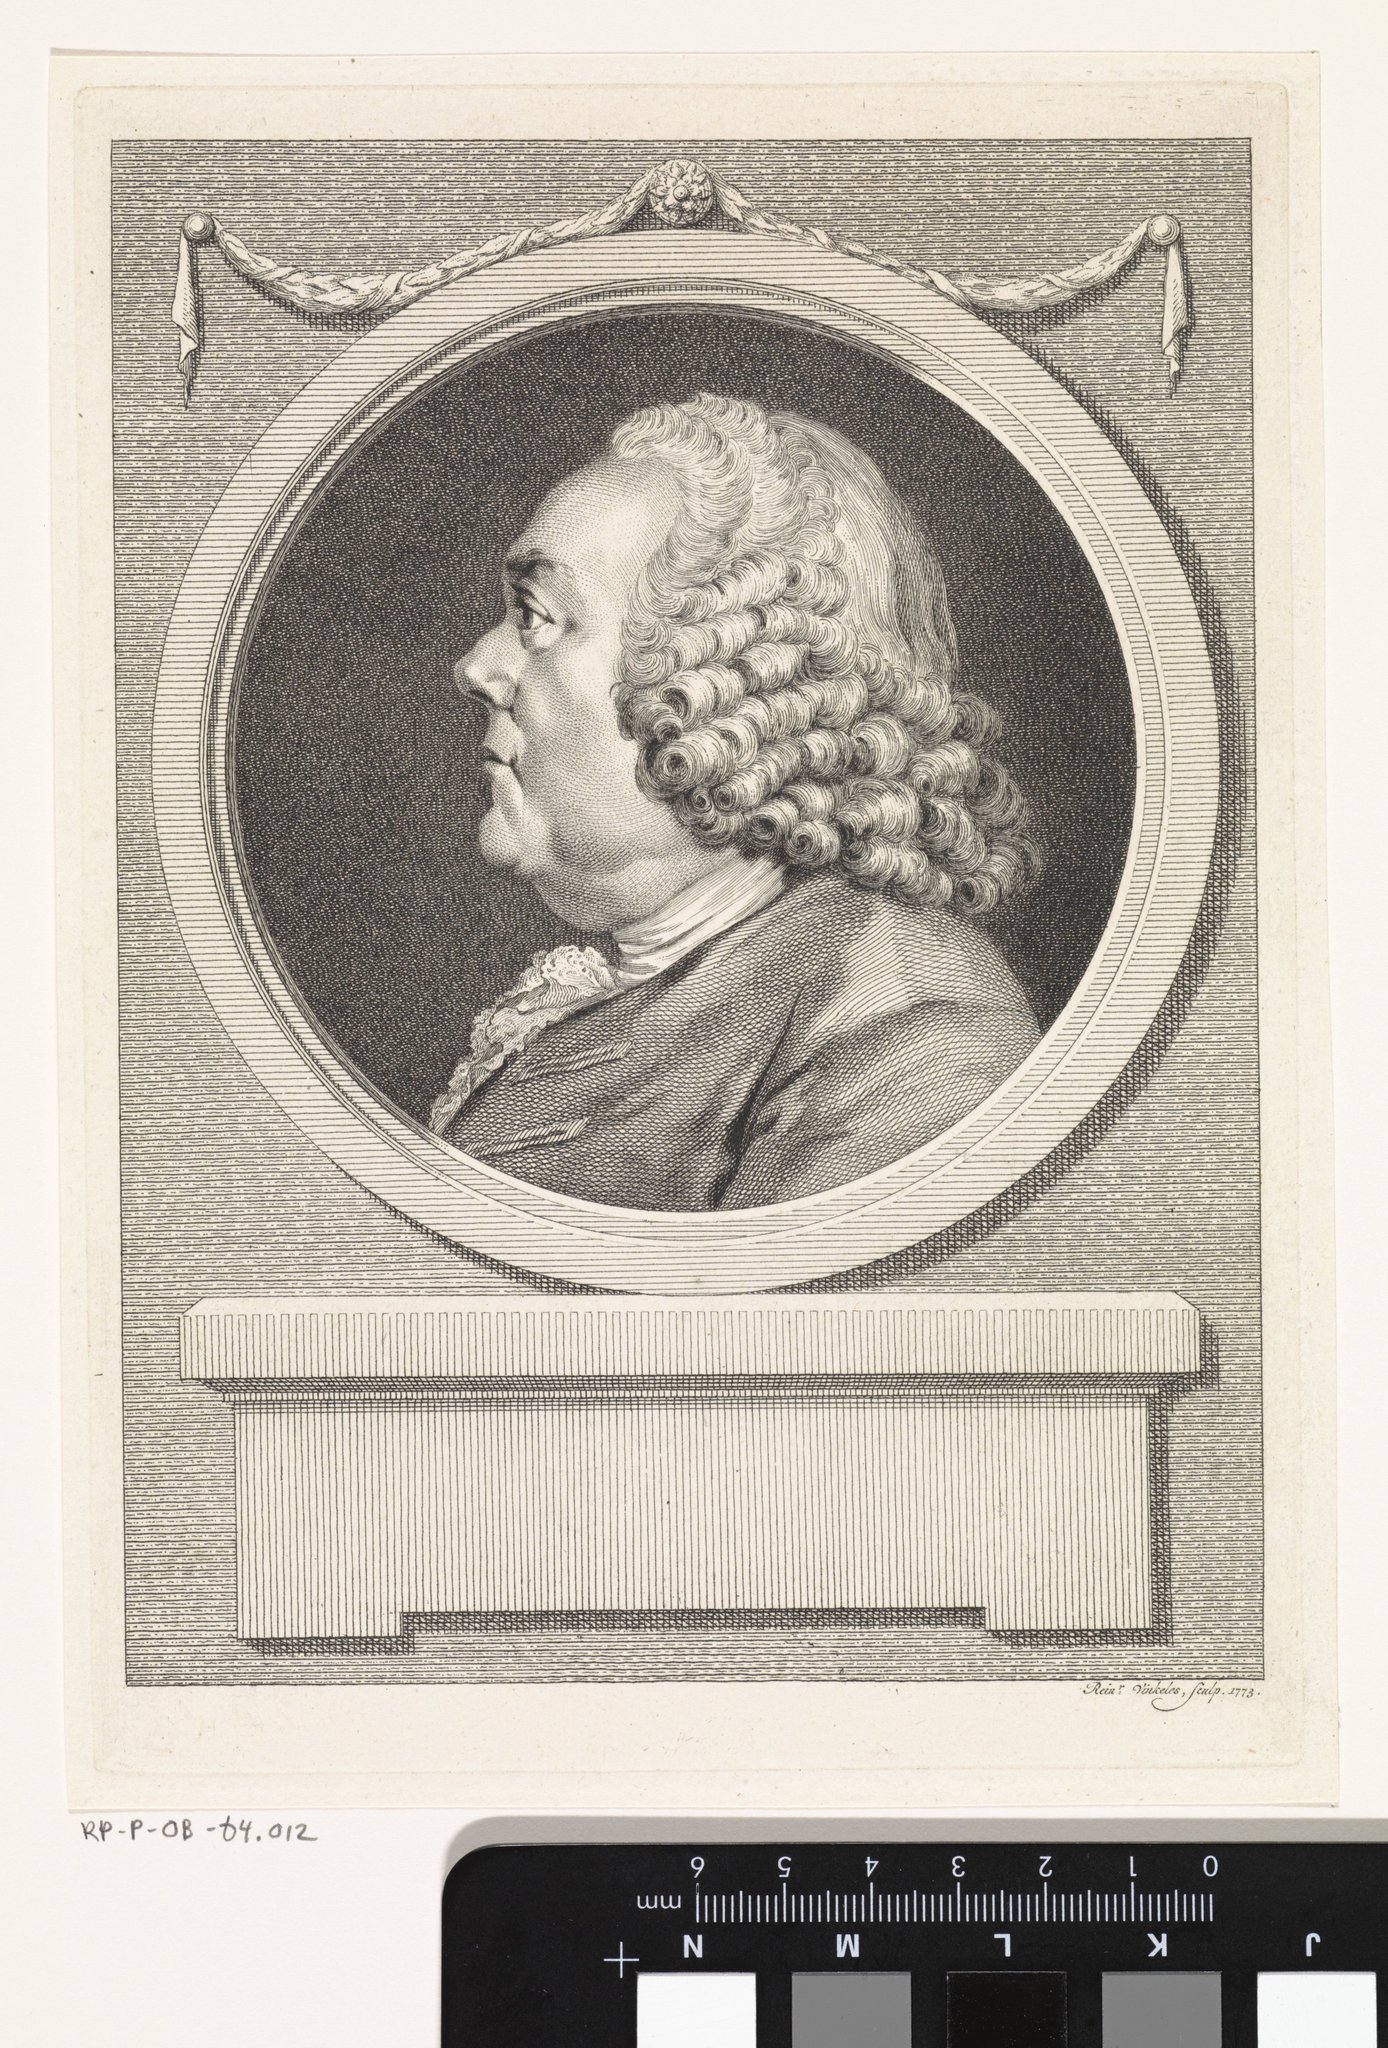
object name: print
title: Portret van Gerard baron van Swieten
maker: reinier vinkeles (i)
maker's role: draughtsman, print maker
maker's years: 1741-1816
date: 1773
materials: paper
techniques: engraving, etching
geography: amsterdam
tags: leiden, vienna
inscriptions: collector's mark: Lugt 240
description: Portret van Gerard baron van Swieten, medicus en hoogleraar te Leiden en Wenen.